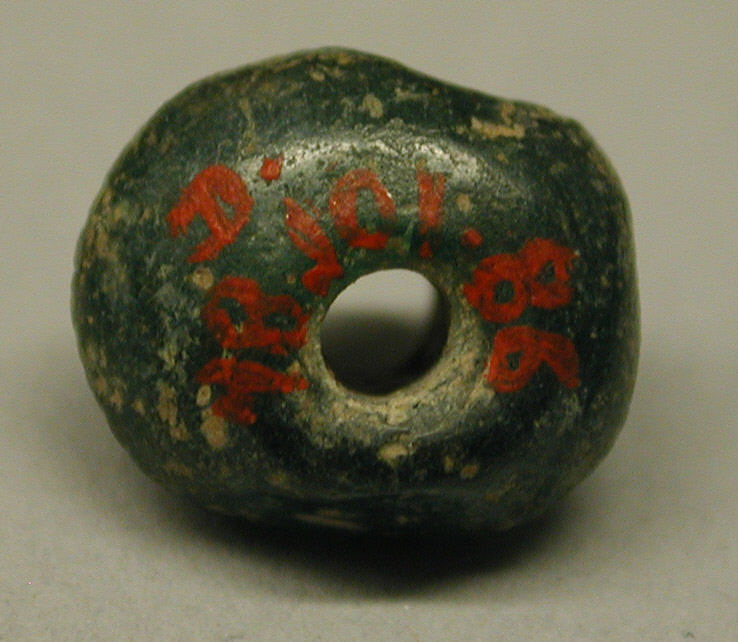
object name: bead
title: Beads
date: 801-1200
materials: glass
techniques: cutting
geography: iran